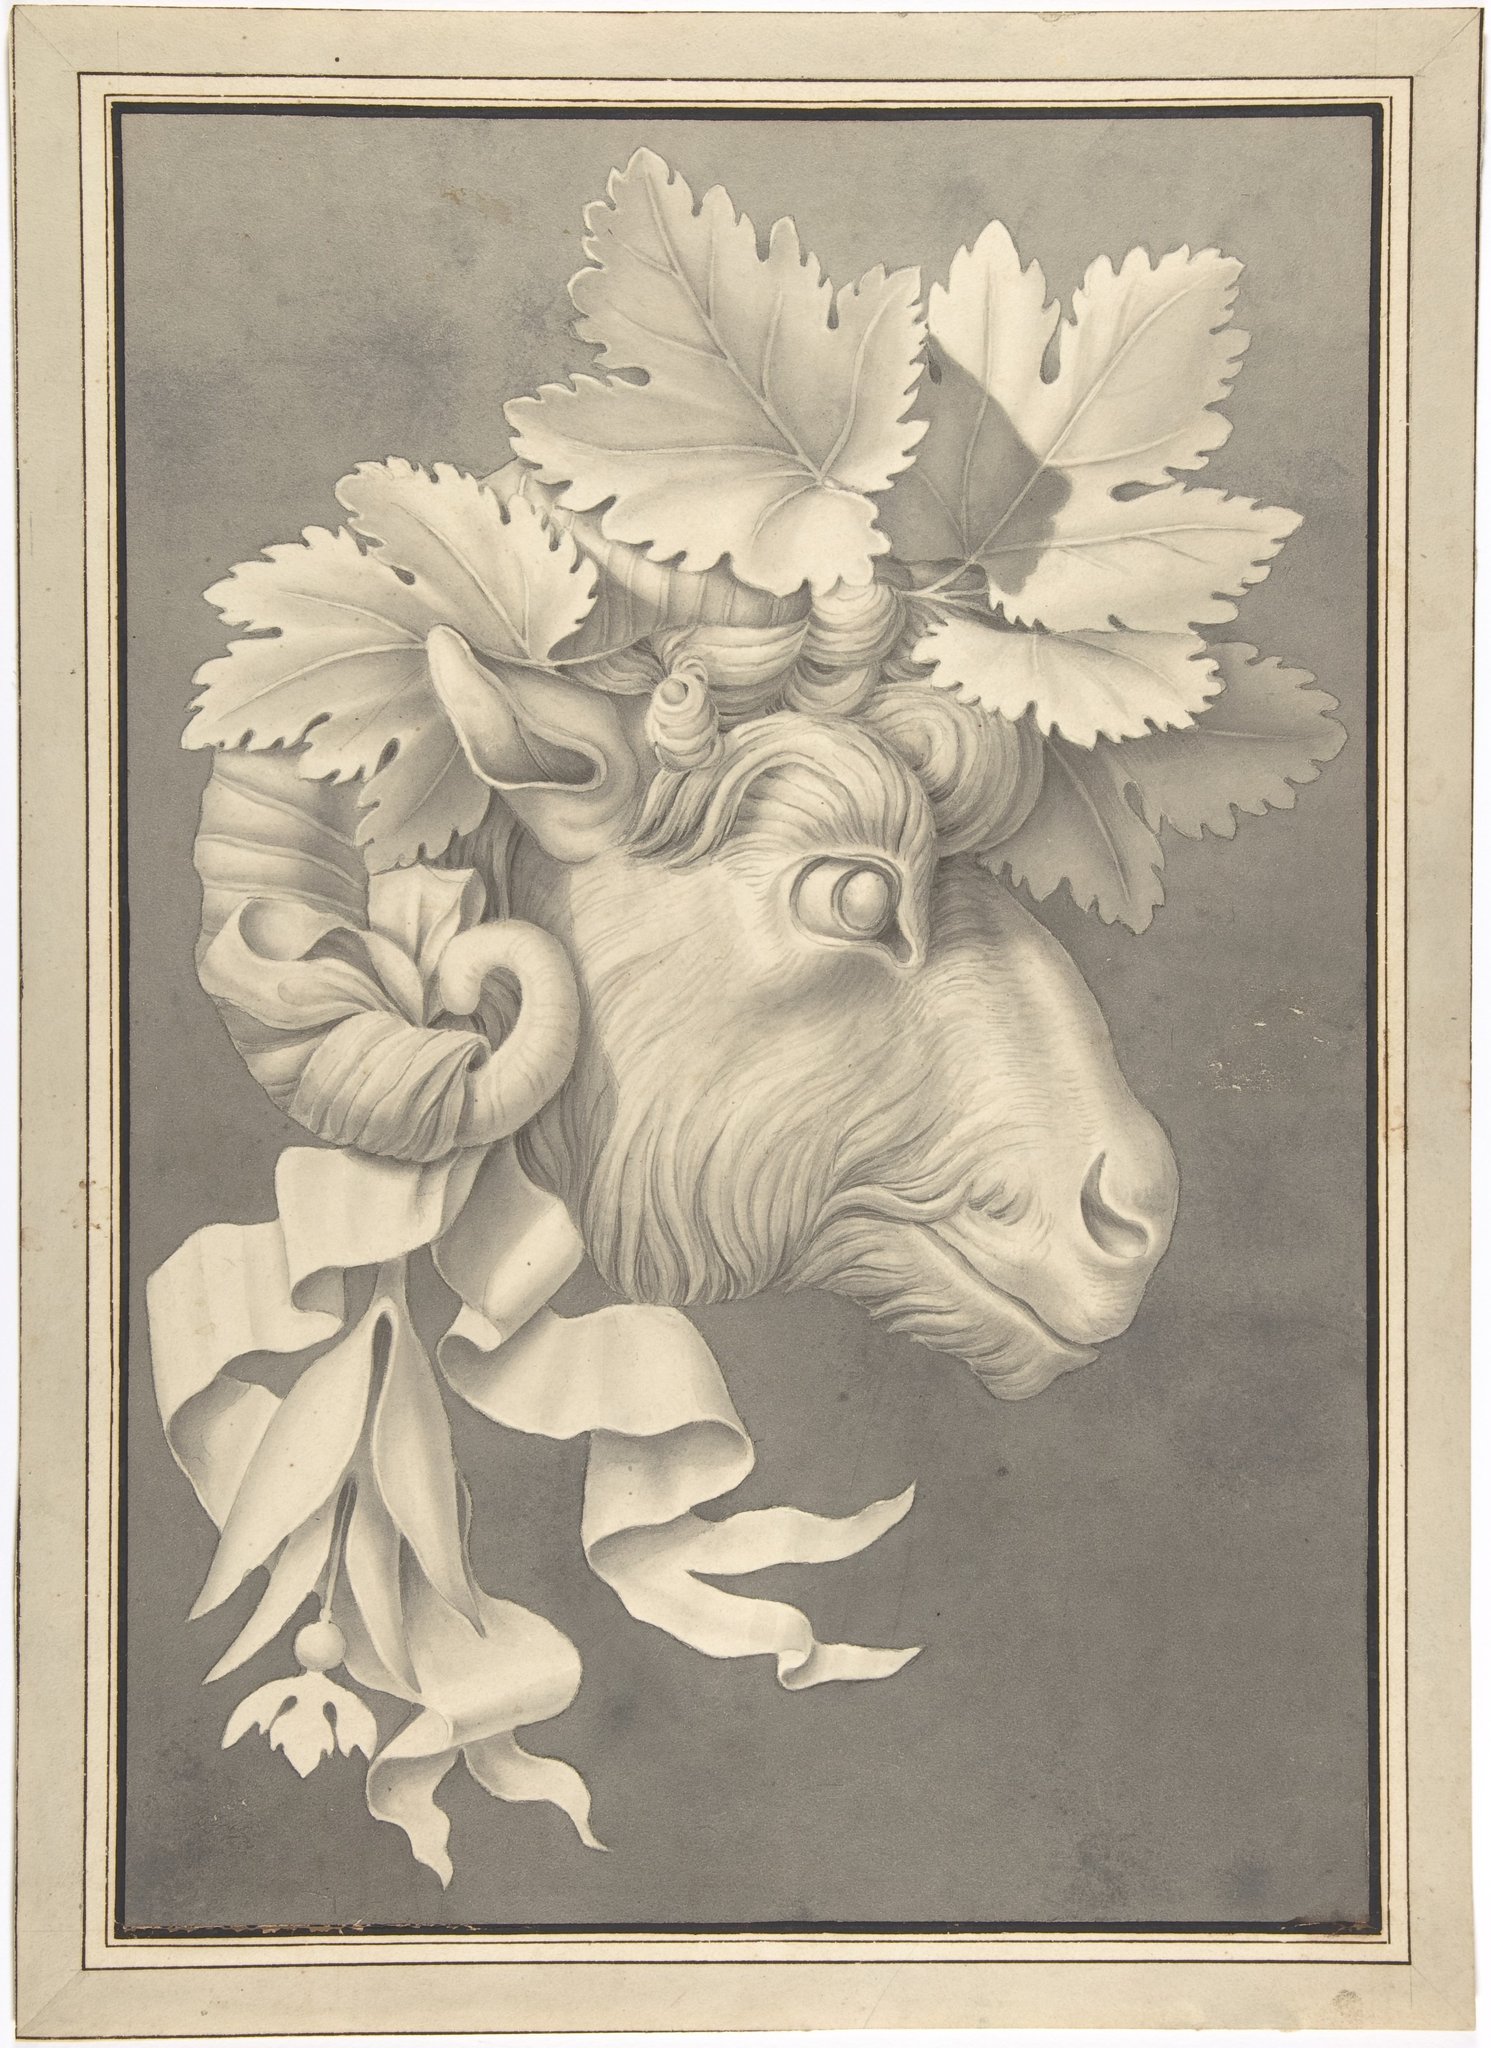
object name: drawing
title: Decorative Ram's Head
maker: anonymous, british, 19th century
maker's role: artist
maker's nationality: british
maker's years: 1800-1900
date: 1801-1850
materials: ink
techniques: brush, pen, wash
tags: heads,rams,leaves